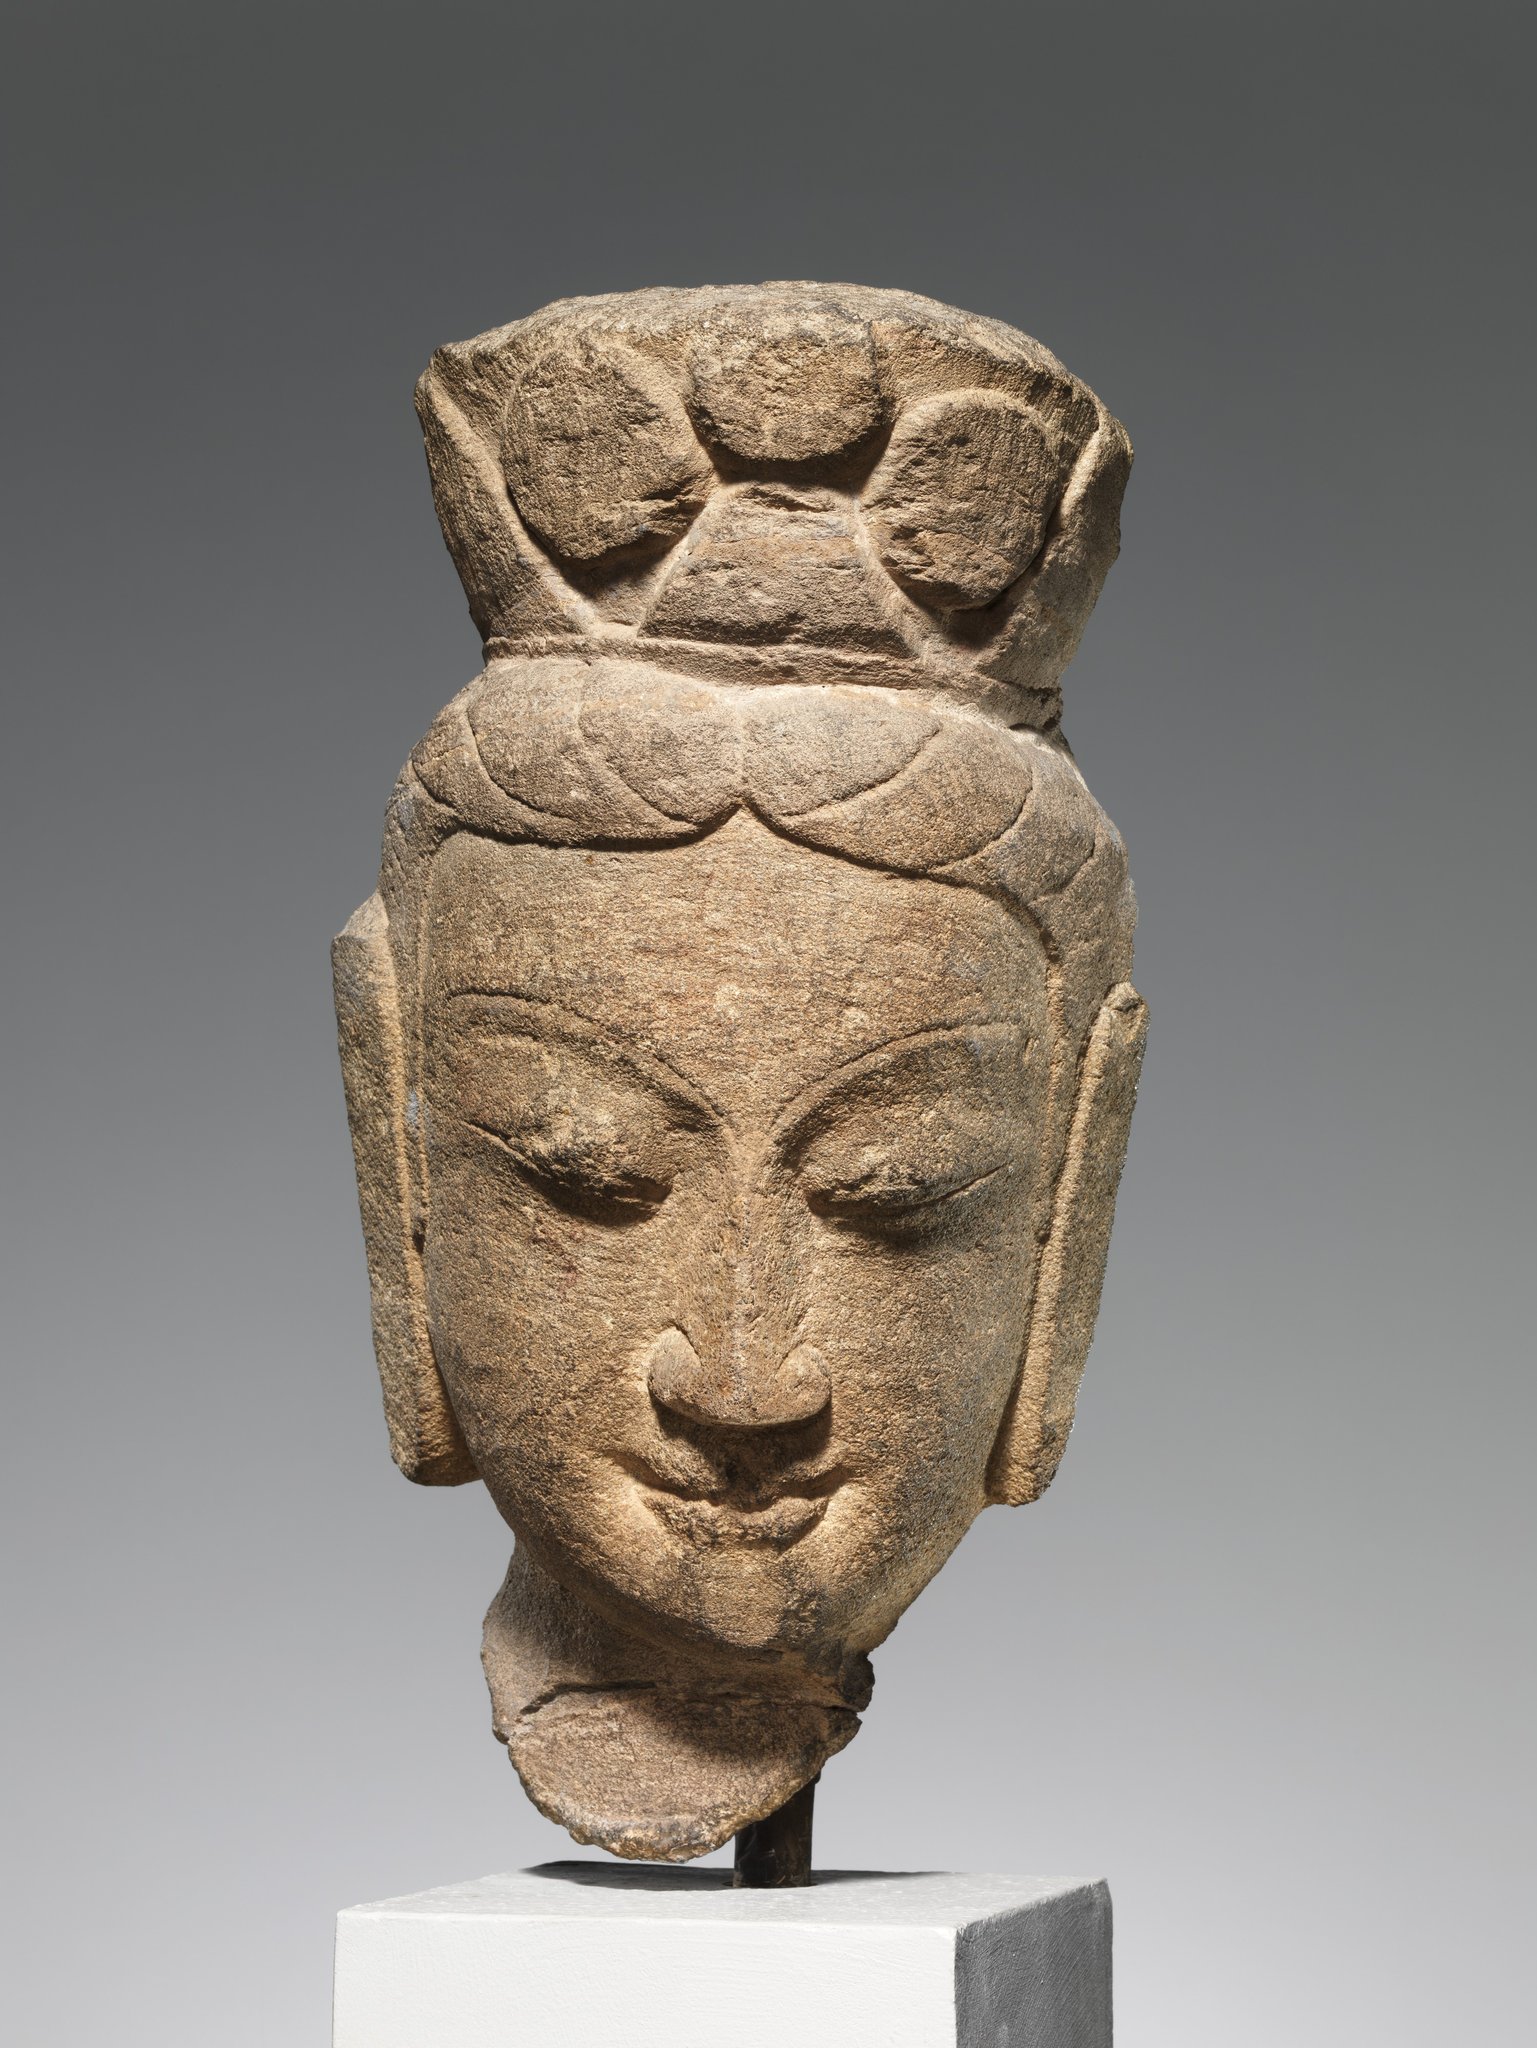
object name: head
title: Head of a bodhisattva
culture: chinese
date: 467-500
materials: pigment, stone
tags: heads,buddhism,bodhisattvas